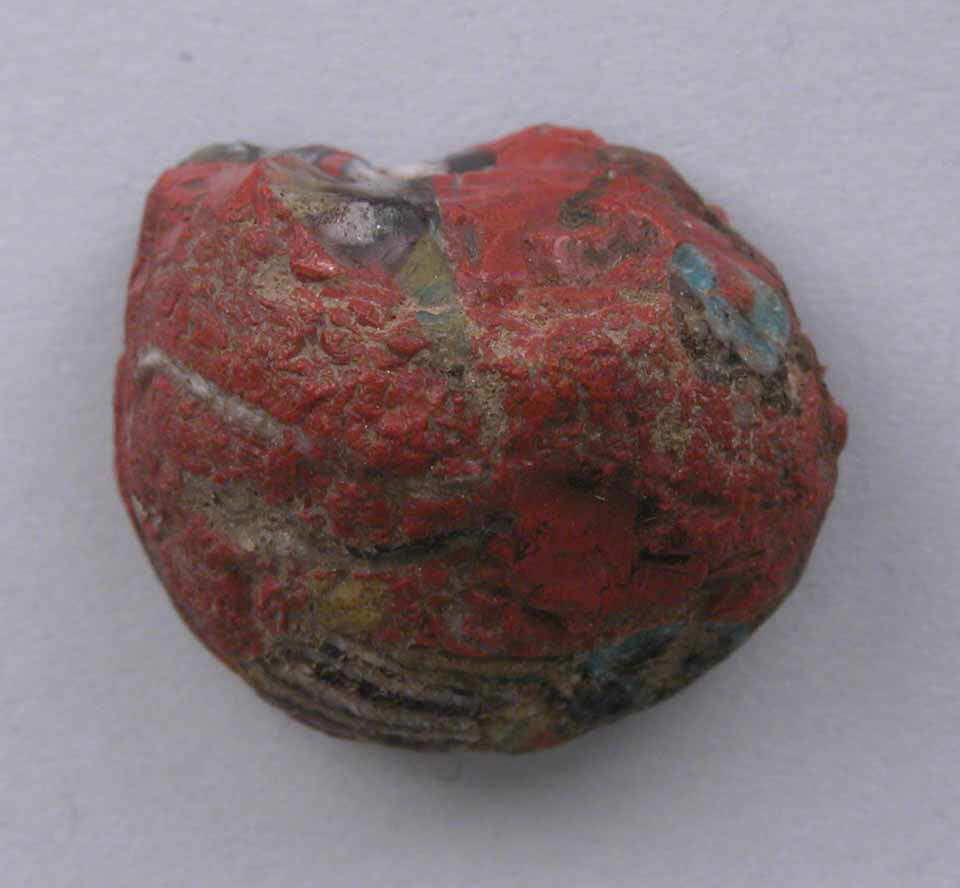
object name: element with a domical shape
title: Overfired Millefiori Glass with a Domical Shape, Perhaps a Pawn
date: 201-1200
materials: glass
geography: egypt